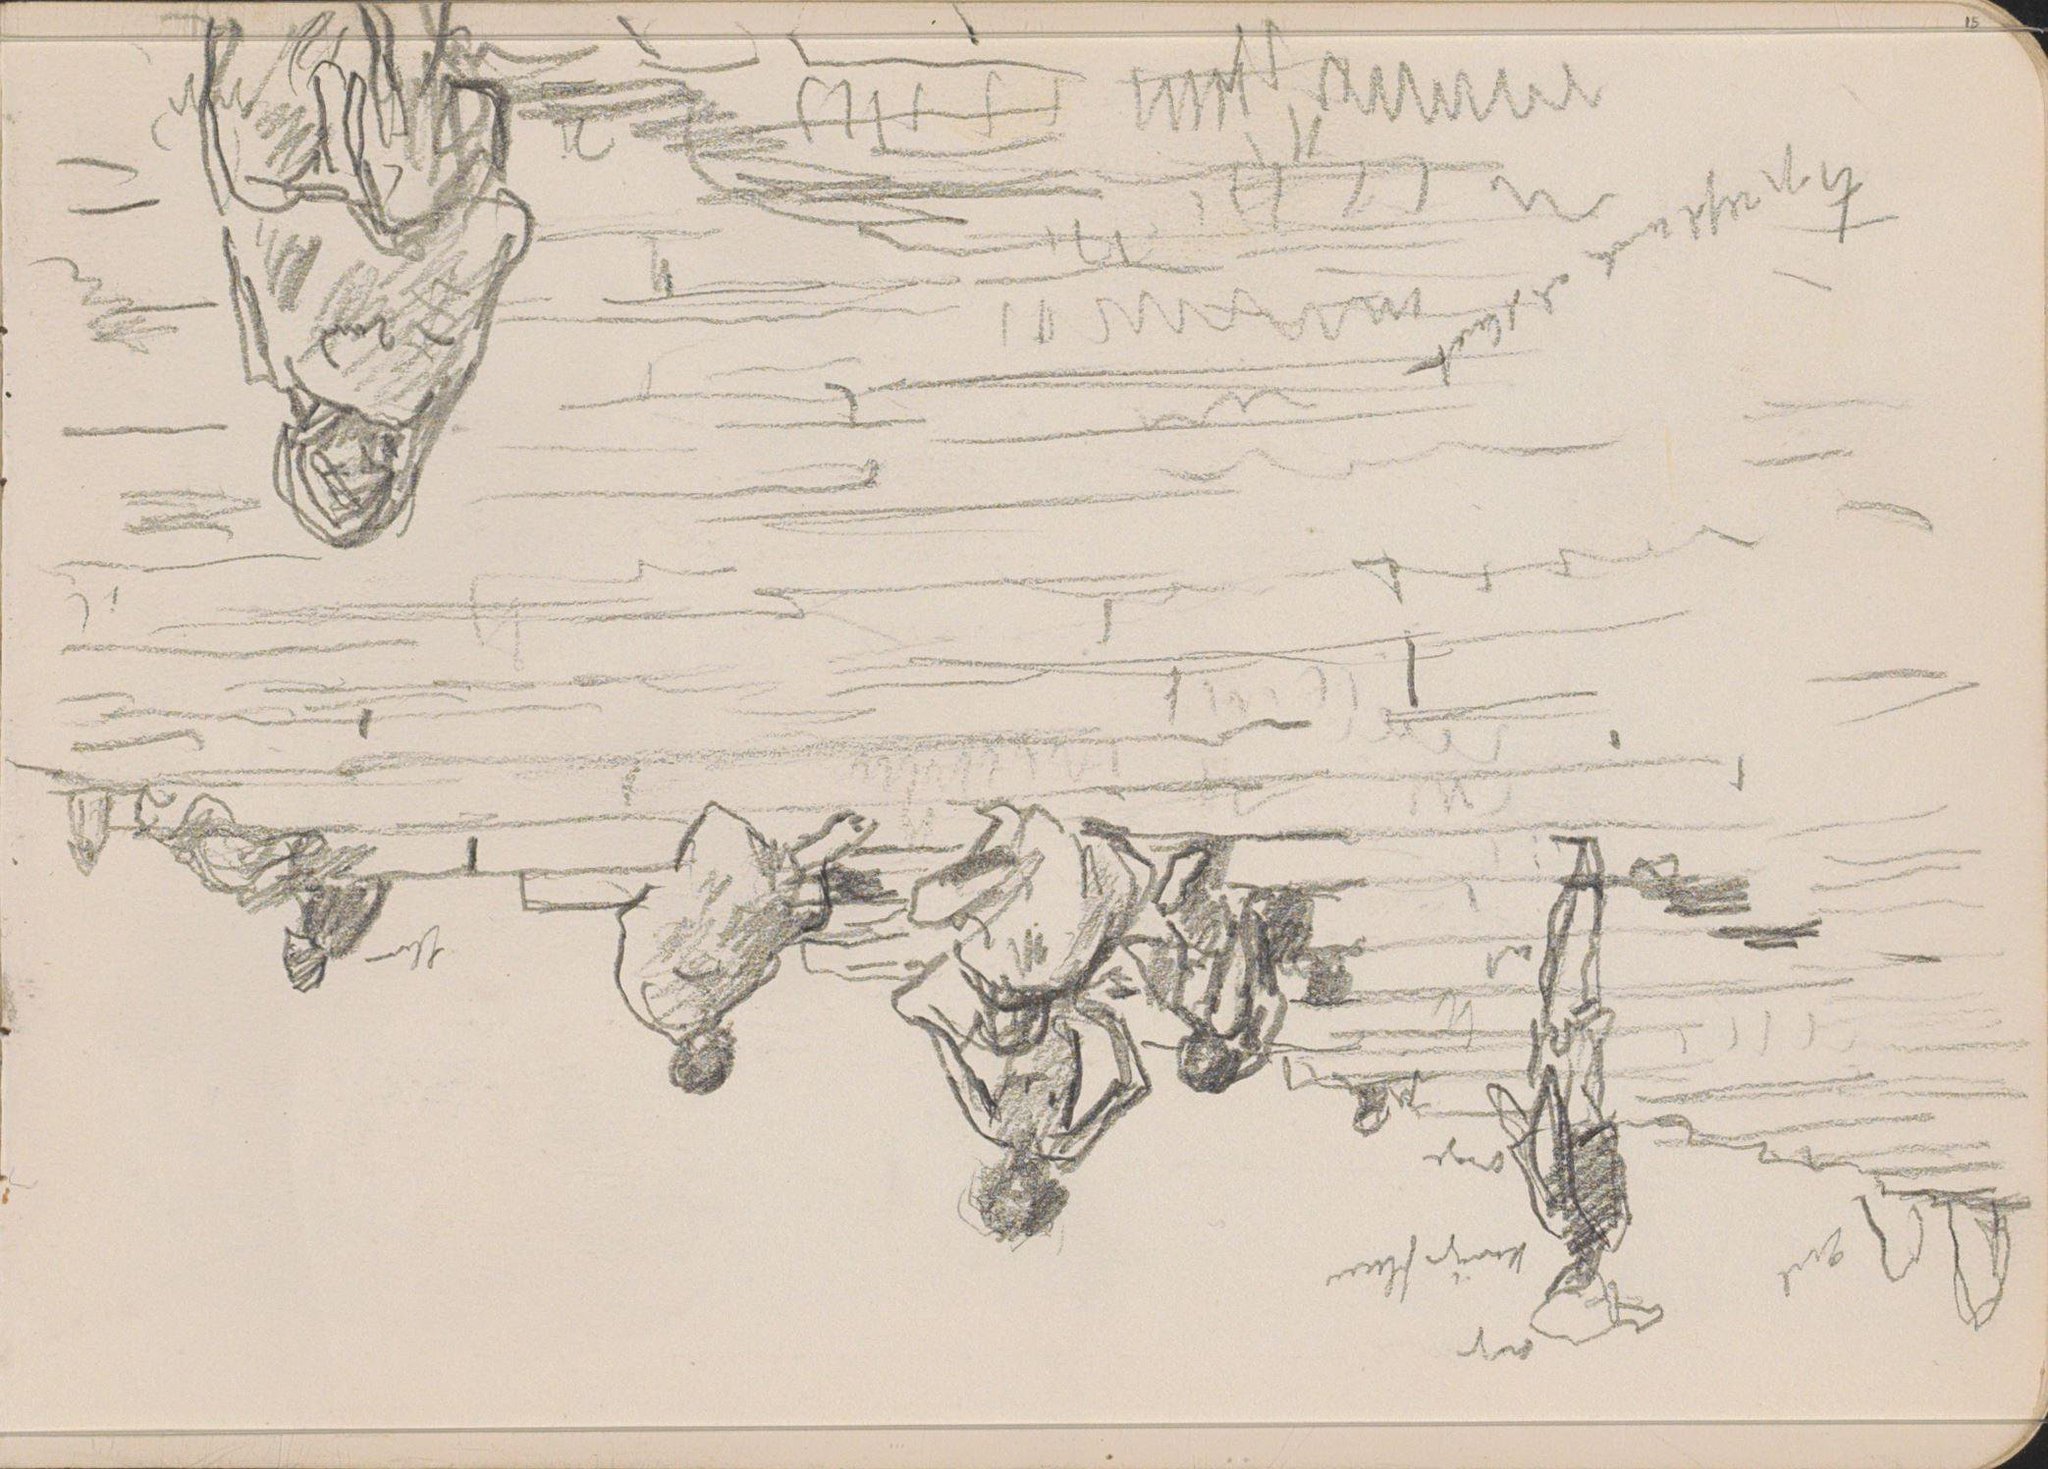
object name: sketchbook leaf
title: Indiërs op een trap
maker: marius bauer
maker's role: draughtsman, print maker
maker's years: 1867-1932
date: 1925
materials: paper, pencil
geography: india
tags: standing figure, sitting figure, flight of steps, asiatic races and peoples: indians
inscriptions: kleurnotitie, handgeschreven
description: Pagina 15 uit een schetsboek met 15 bladen.